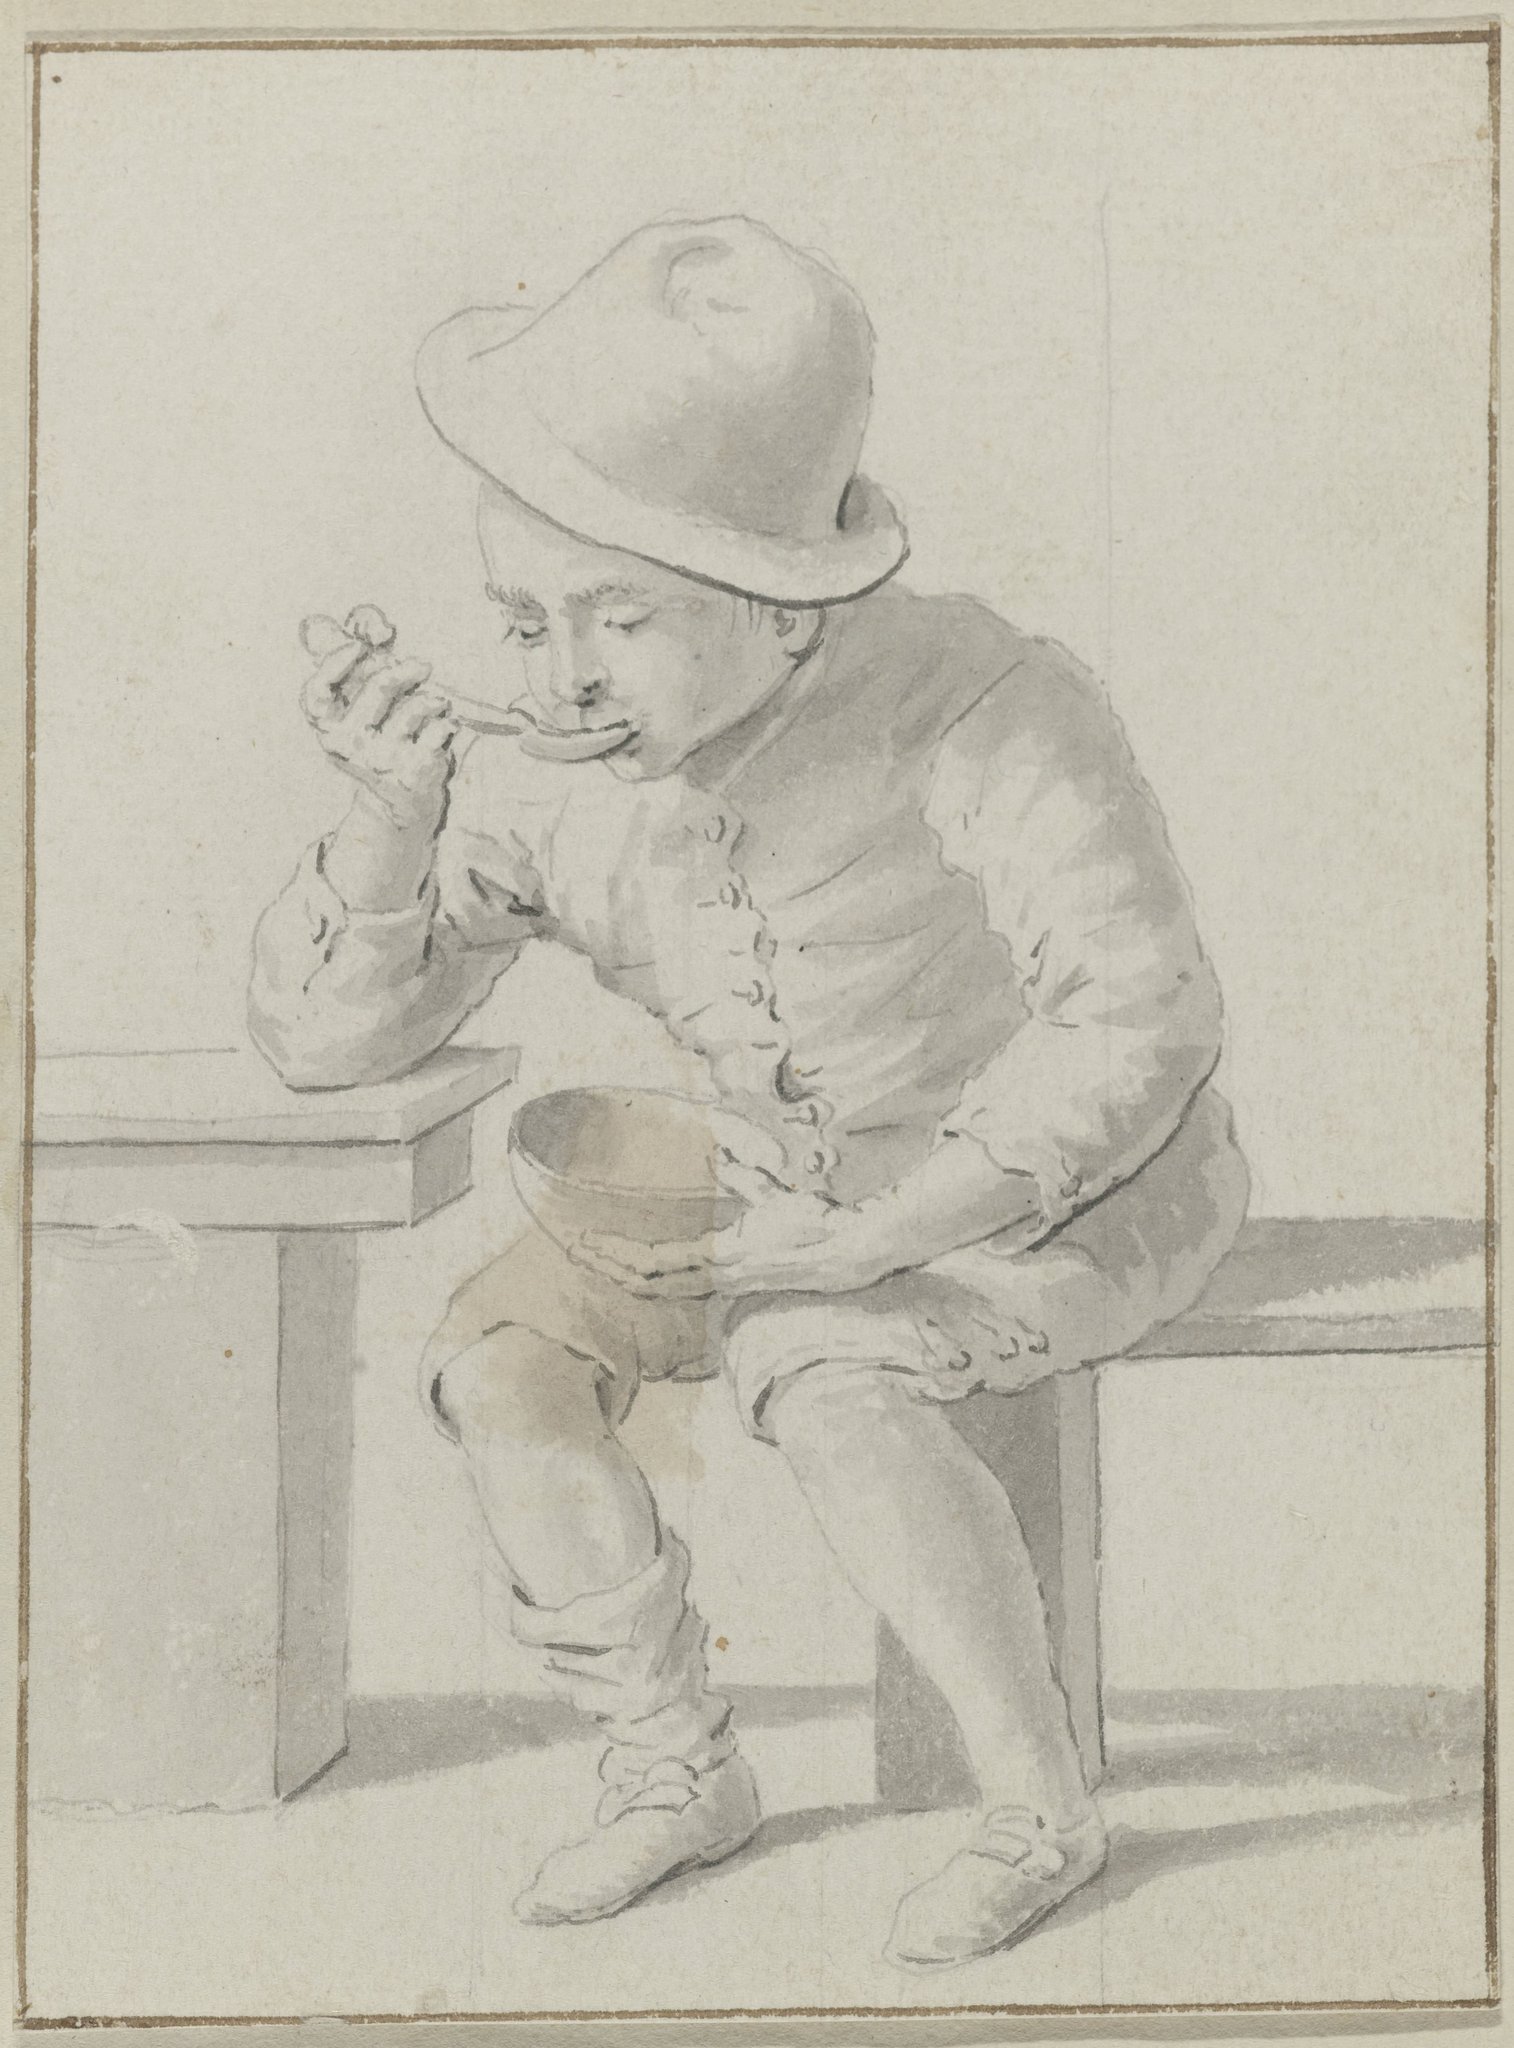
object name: drawing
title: Zittende soep etende jongen met hoed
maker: Anonymous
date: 1700-1799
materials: ink, paper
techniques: brush, pen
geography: netherlands